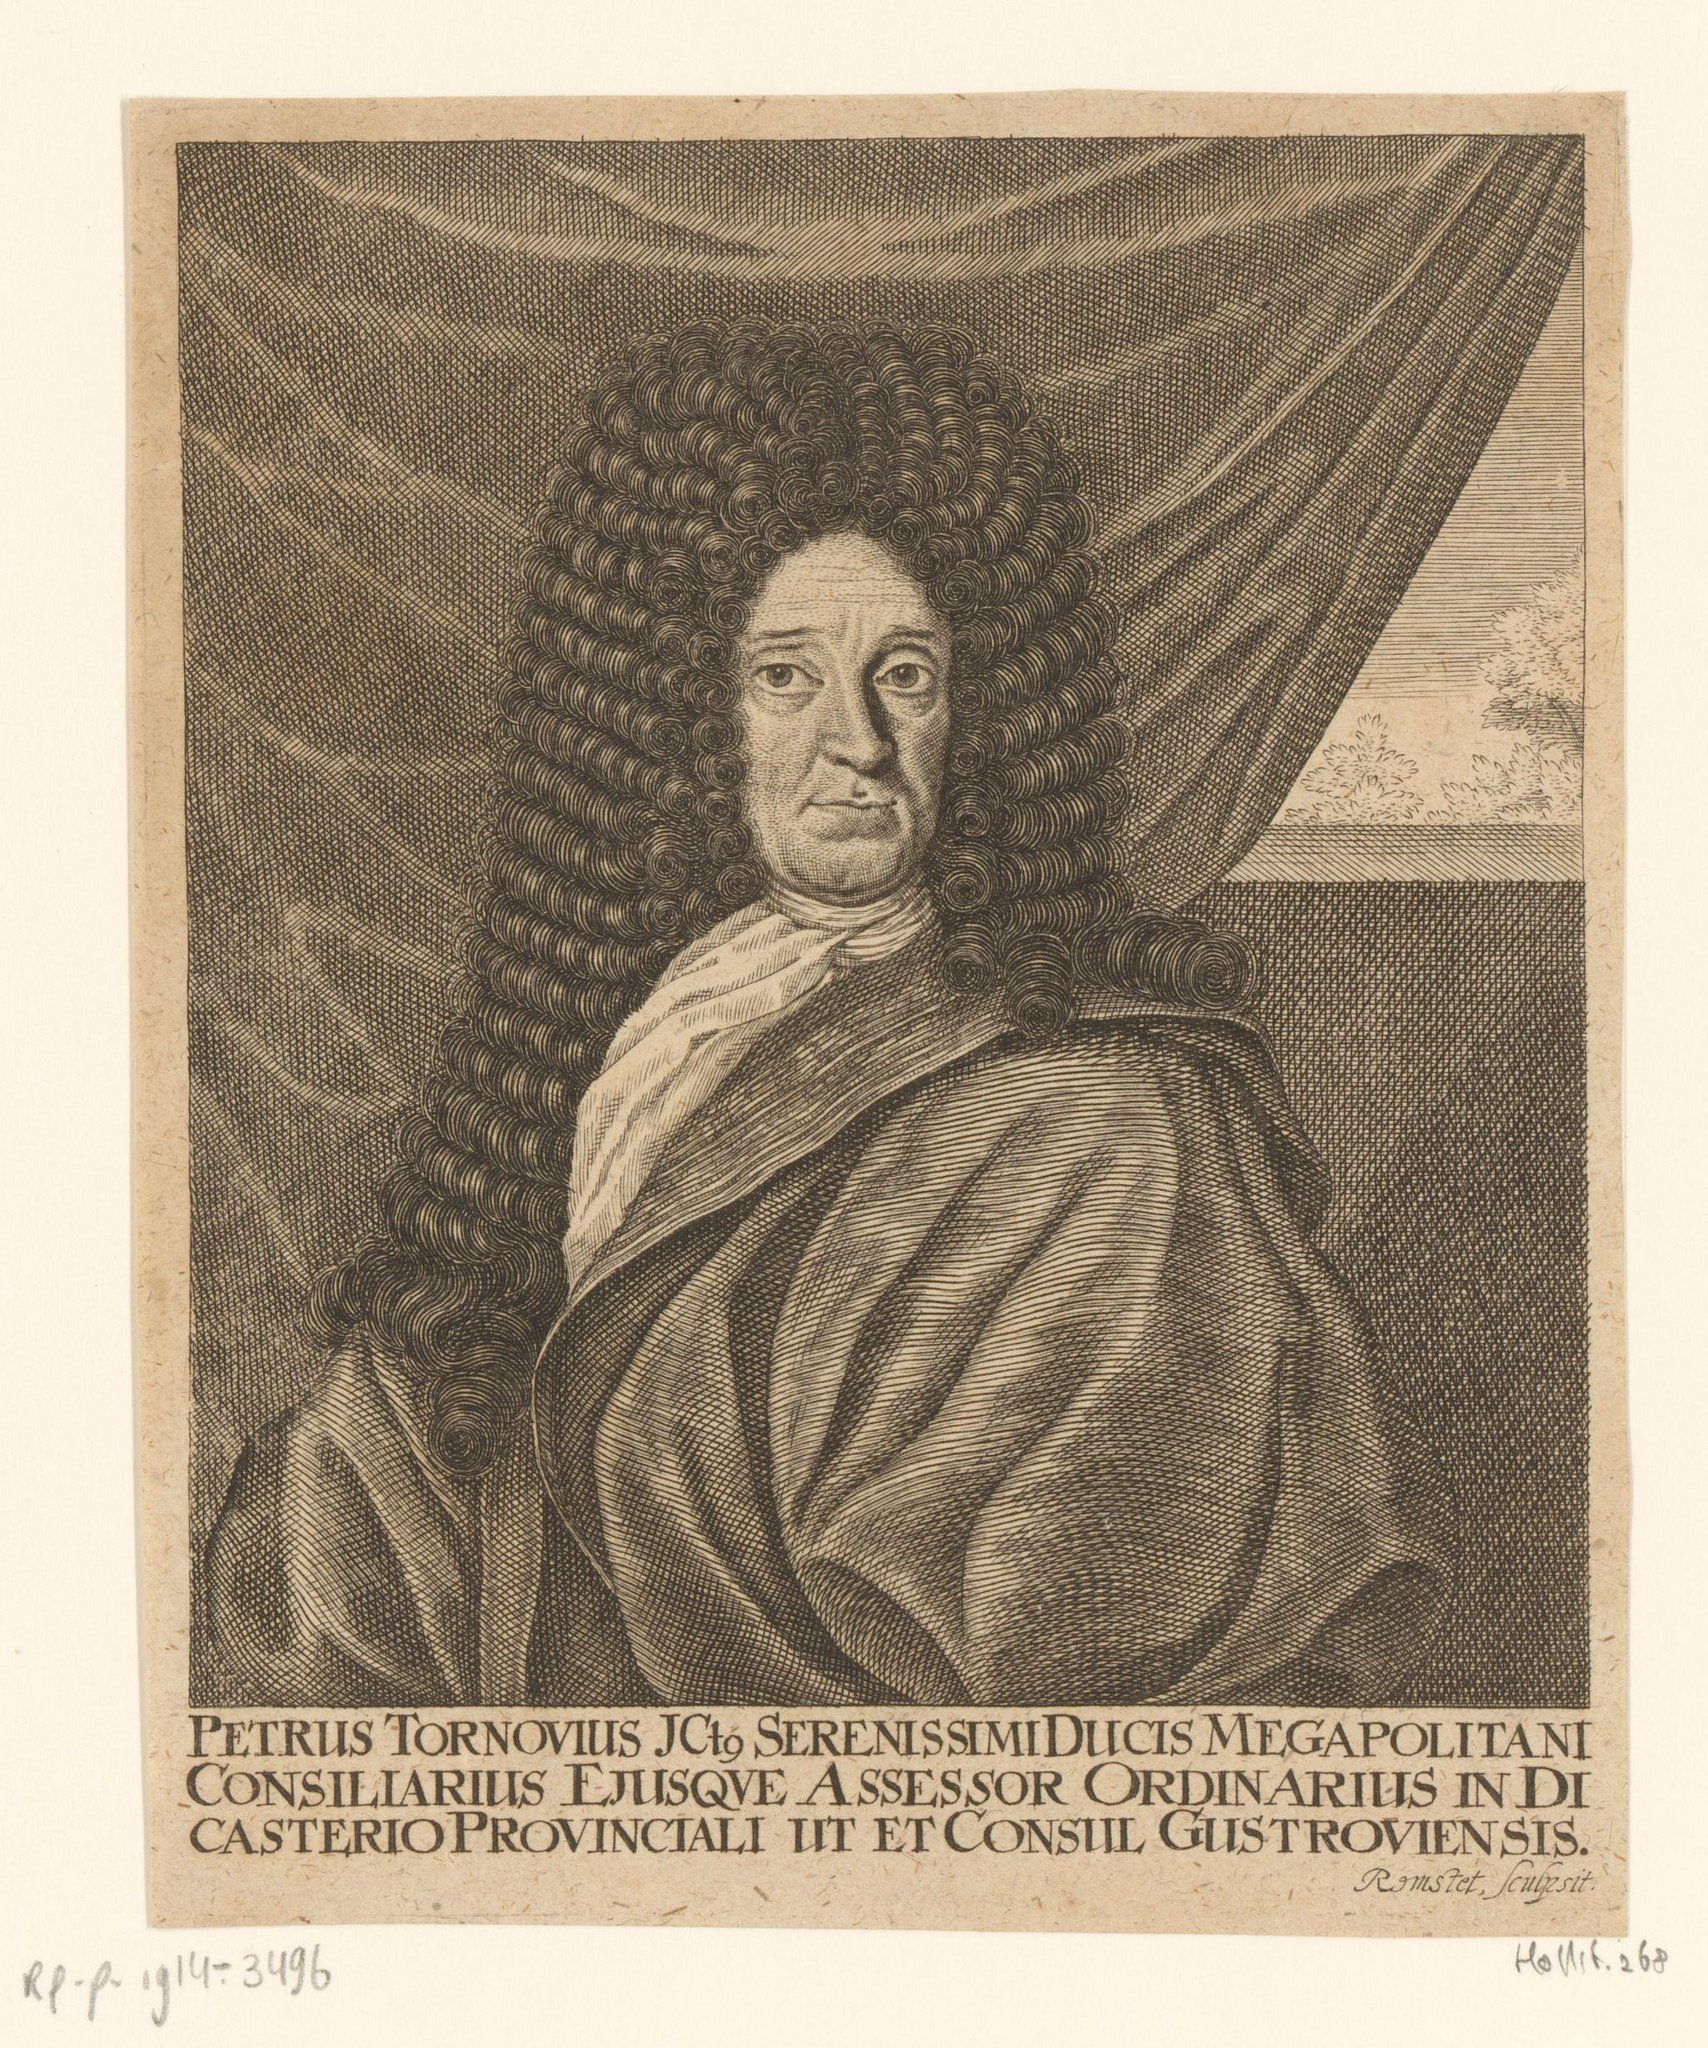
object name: print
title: Portret van Peter Tornovius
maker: christian romstet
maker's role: print maker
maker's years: 1640-1721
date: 1665-1721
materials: paper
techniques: engraving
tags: mayor, historical persons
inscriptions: collector's mark: Lugt 2228